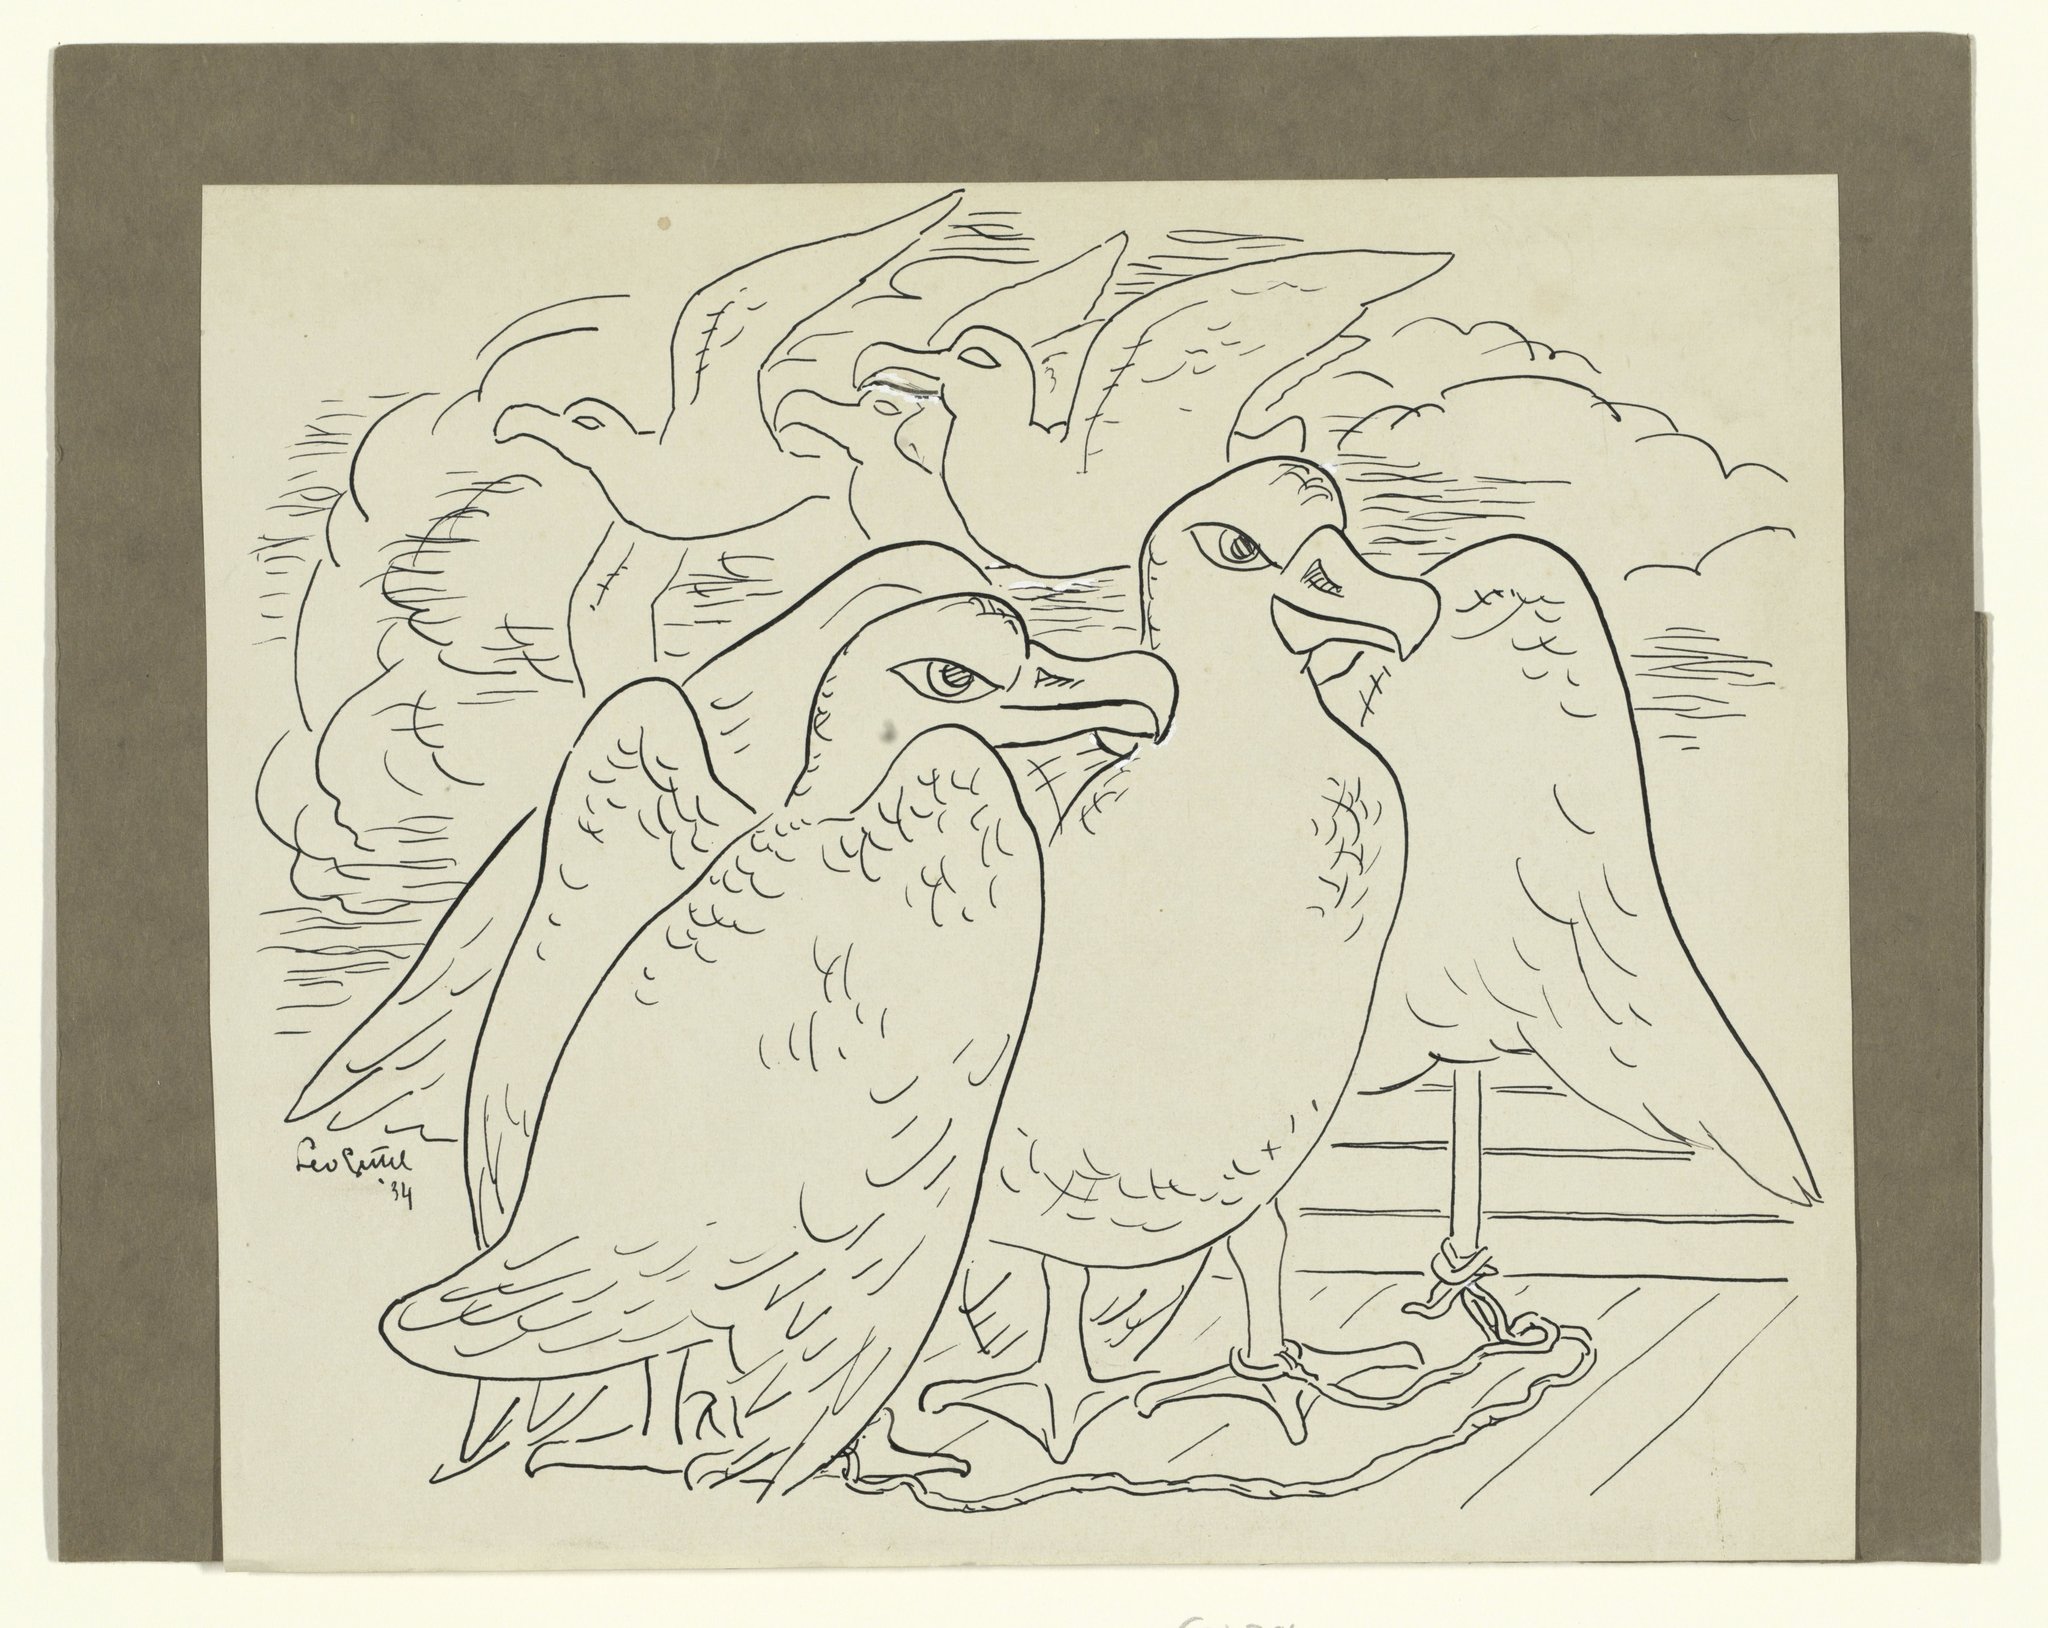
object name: drawing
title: Albatrossen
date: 1934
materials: paint, ink, paper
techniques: pen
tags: (baudelaire, l'albatros) specific works of literature (with author, title), water-birds: albatross, illustration ~ printed matter, book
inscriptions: date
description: Onder de tekening het gedicht L'albatros.